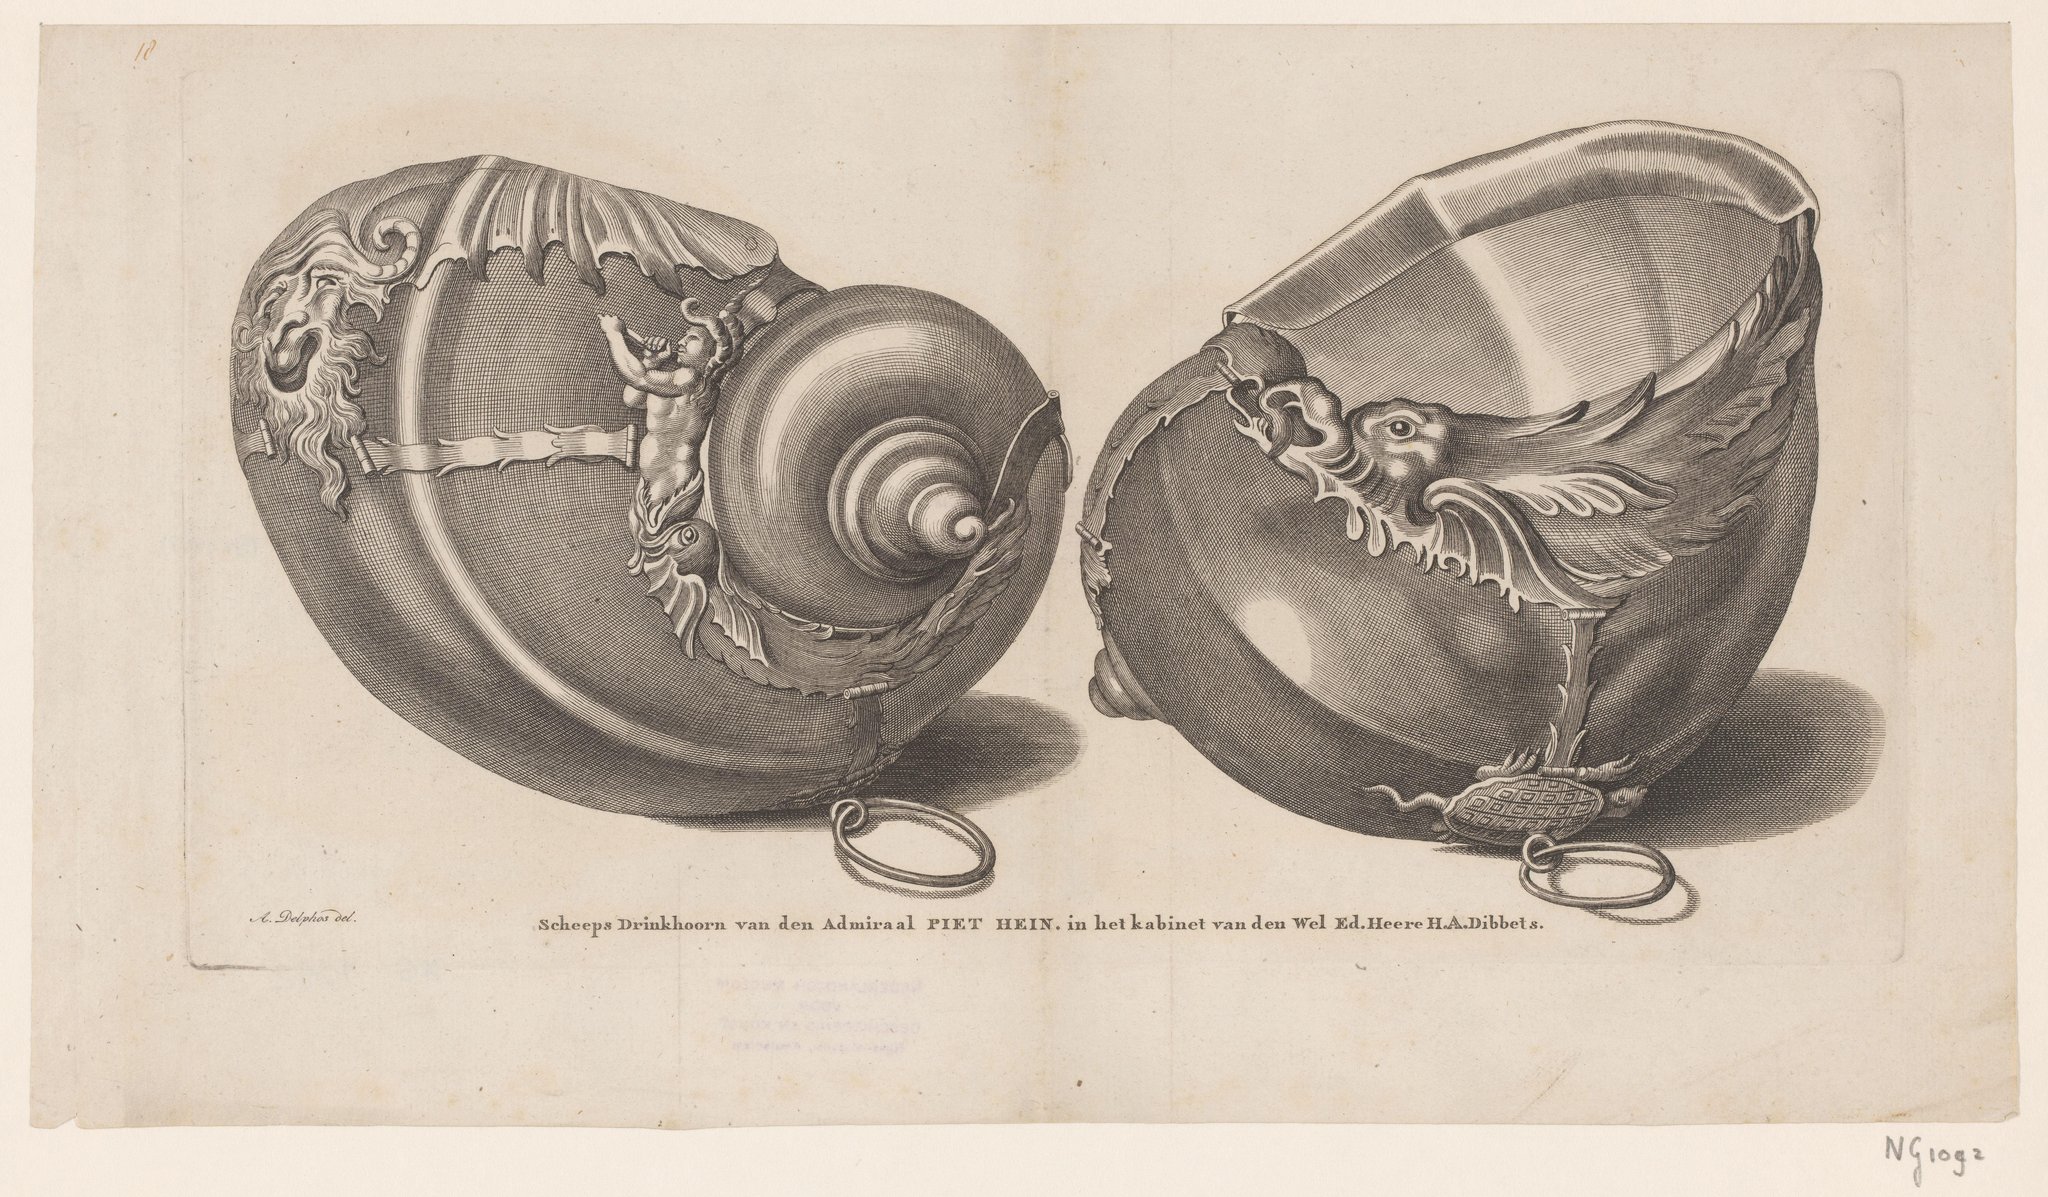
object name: print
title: Scheeps Drinkhoorn van den Admiraal Piet Hein, in het kabinet van den Wel Ed. Heere H.A. Dibbets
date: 1780-1782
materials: paper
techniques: etching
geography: northern netherlands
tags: delfshaven, warmond, hendrik albert dibbets, drinking-vessel in unusual shape, drinking-horn, capture of the spanish treasure fleet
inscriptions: collector's mark: ‘Nederlandsch Museum voor Geschiedenis en Kunst / Rijks-Museum, Amsterdam’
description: De scheepsdrinkhoorn van Piet Hein in het kabinet van H.A. Dibbets. Een met zilver beslagen schelp, met zeewezens en ornamenten, gezien van twee zijden.